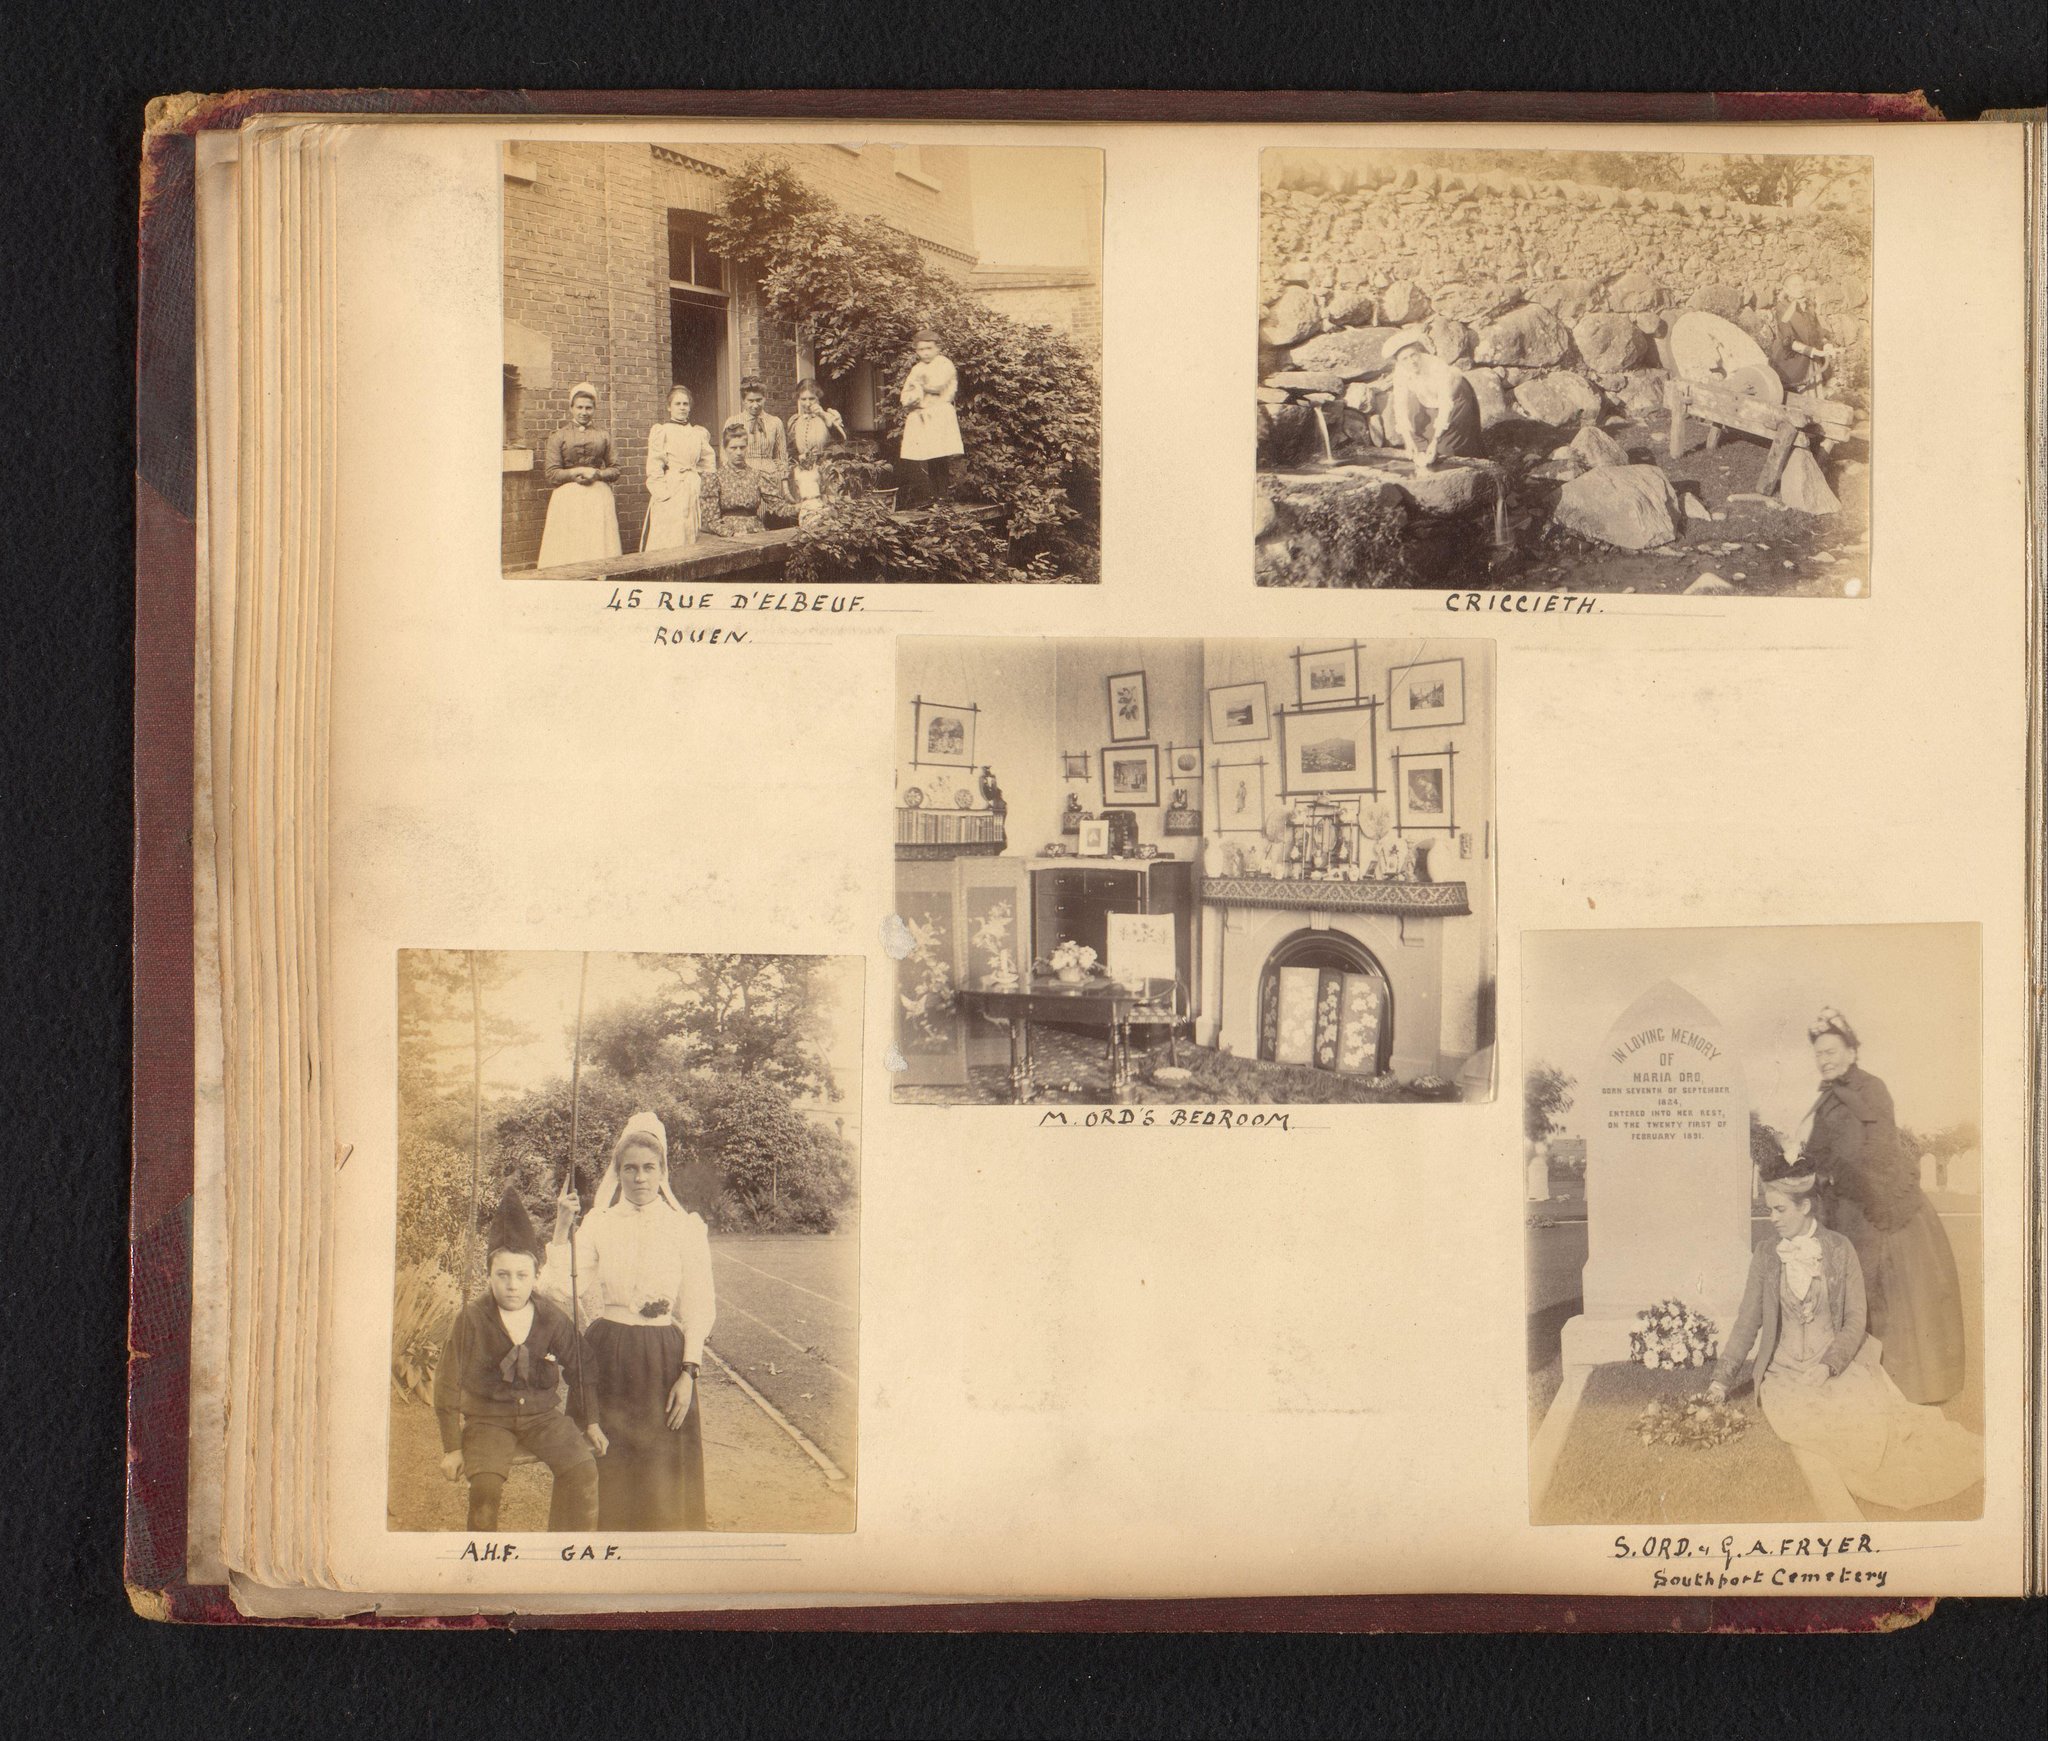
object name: album leaf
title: Diverse onderwerpen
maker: Anonymous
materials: photographic support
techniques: albumen print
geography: europe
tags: adult woman, laying flowers or wreath on grave, child, historical persons, bedroom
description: Groepsportret bij een woning op 45 Rue d'Elbeuf te Rouen, een vrouw bij een waterput te Criccietch, een portret van een jongen en een vrouw, het interieur van de slaapkamer van M. Ord en twee vrouwen, S. Ord en G. A. Fryer, bij het graf van Maria Ord. Deze pagina maakt deel uit van een album.